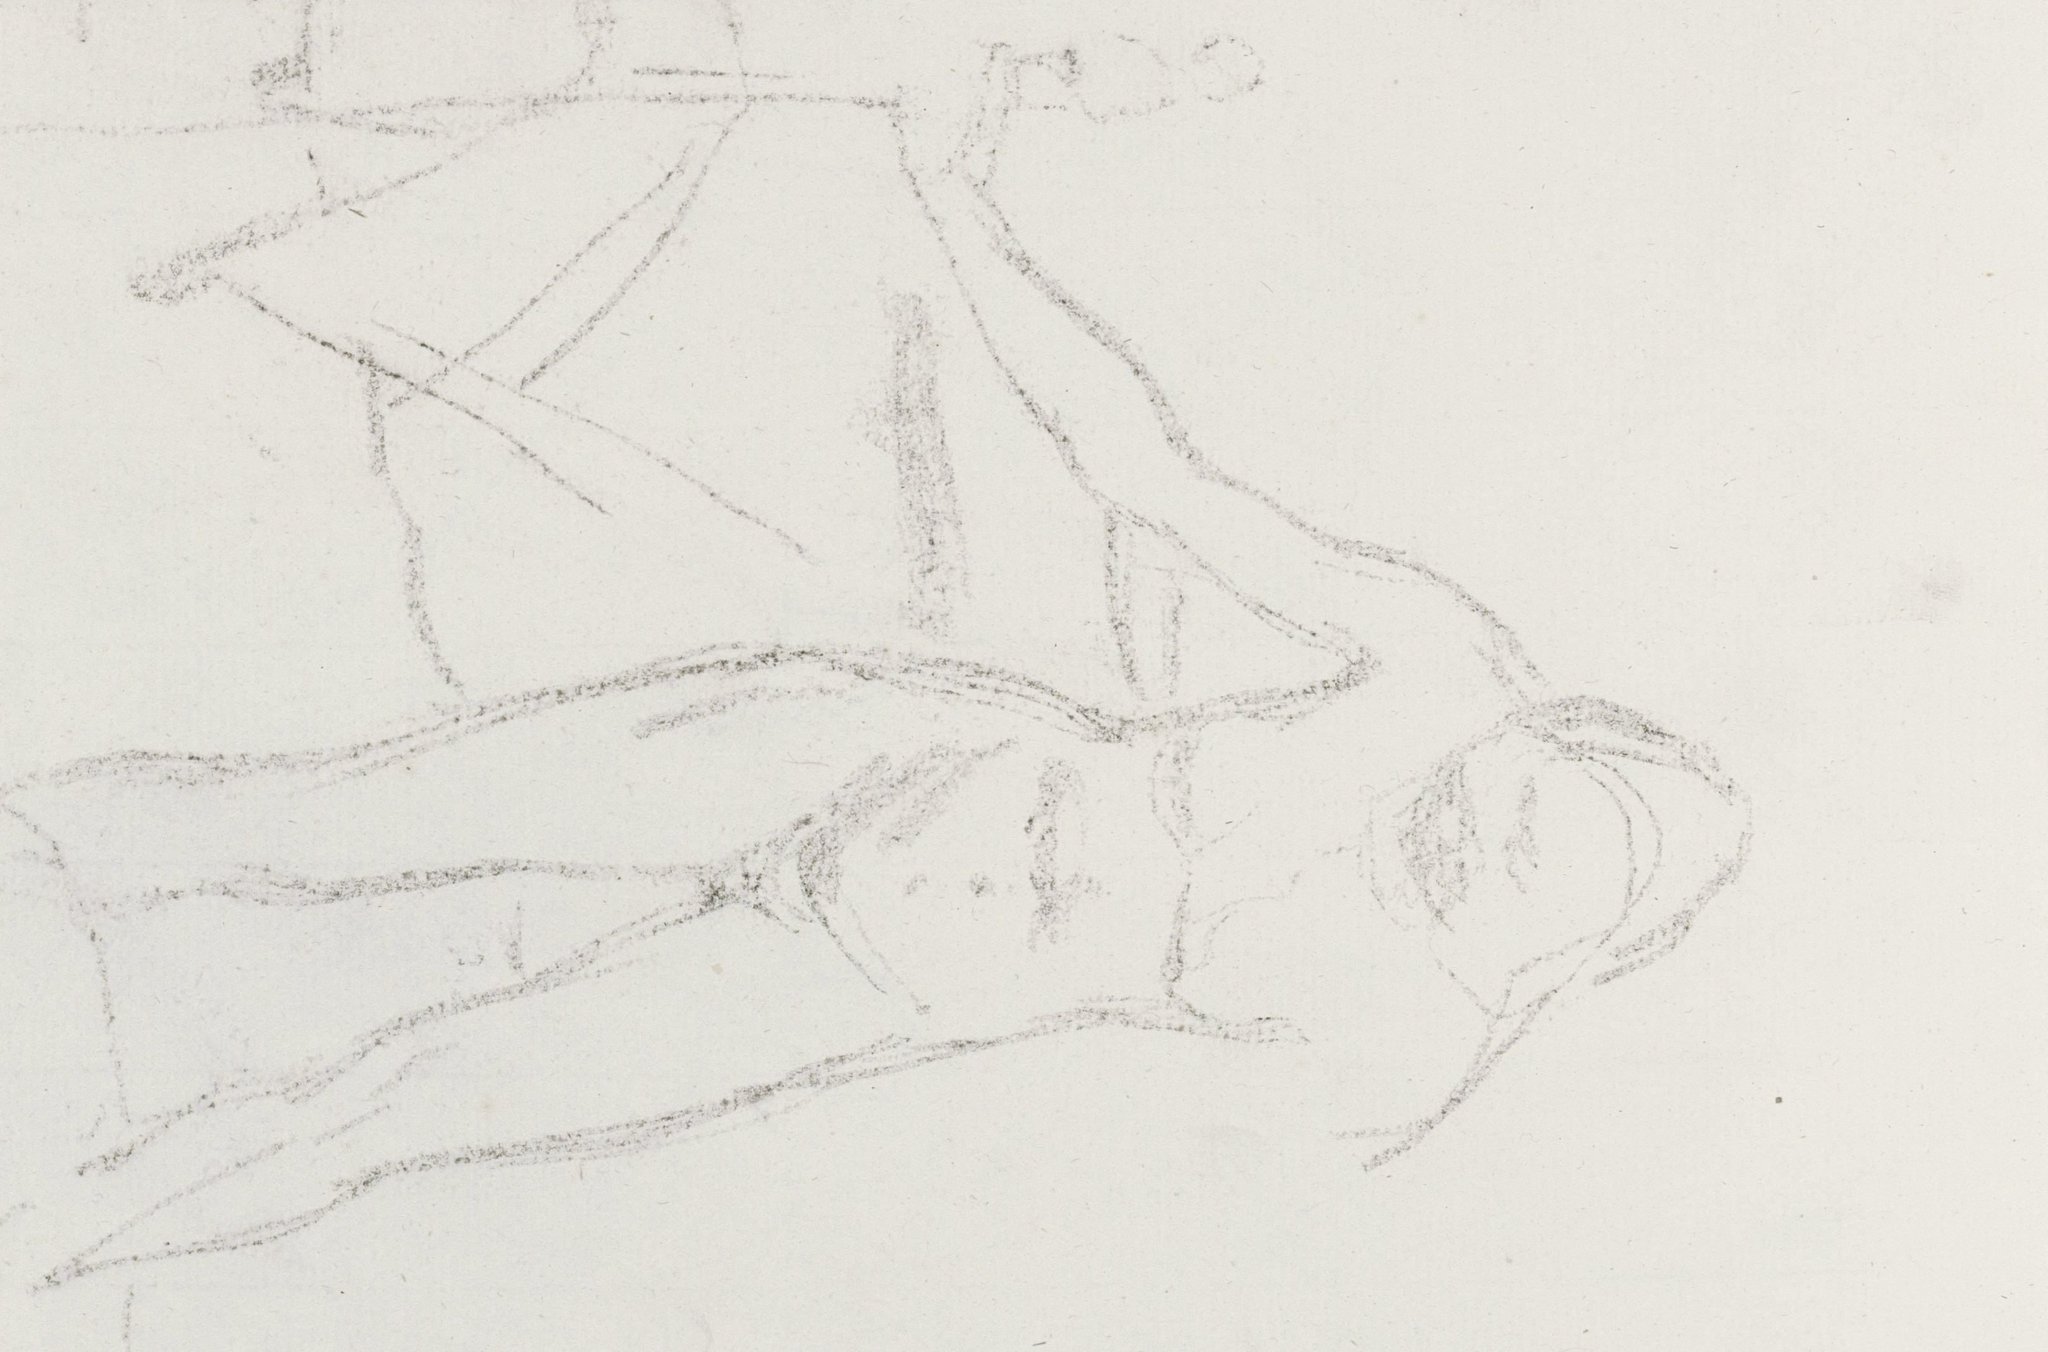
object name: sketchbook leaf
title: Abklatsch van de krijttekening op pagina 9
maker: willem witsen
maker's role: draughtsman, painter, print maker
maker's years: 1860-1923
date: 1887-1892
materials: paper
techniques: printmaking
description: Pagina 8 uit een schetsboek met 17 bladen.